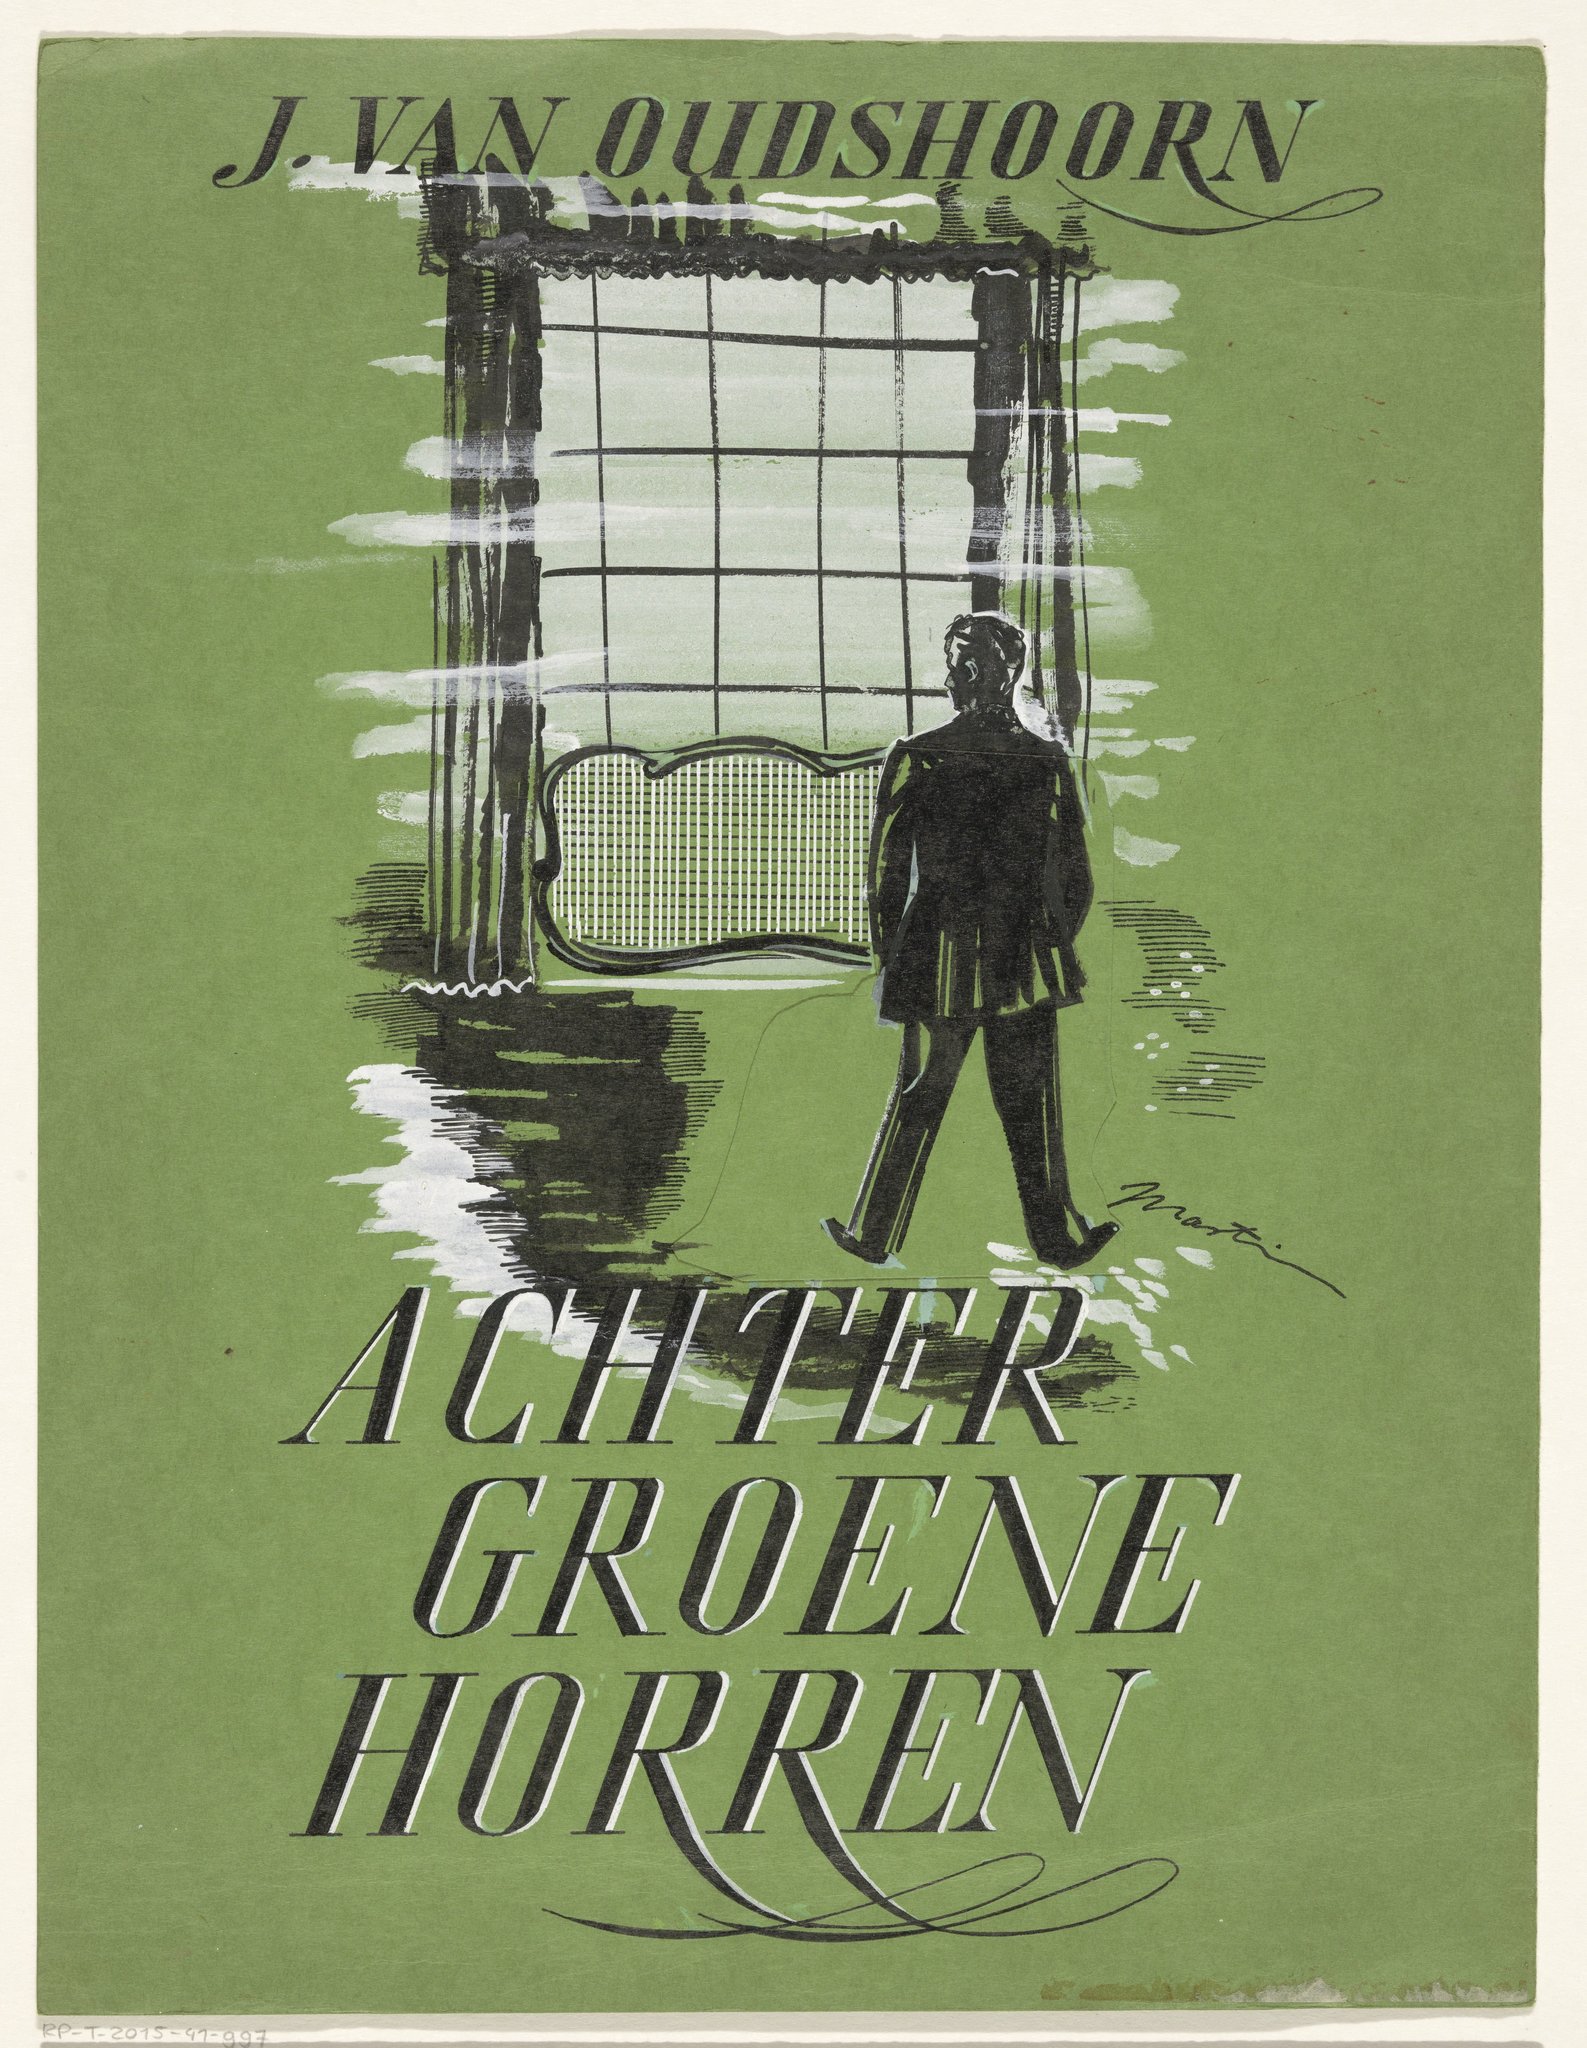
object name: study for binding design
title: Bandontwerp voor: J. van Oudshoorn, Achter groene horren, 1943-1945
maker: martin horwitz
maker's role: print maker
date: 1943-1945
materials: paint, ink, paper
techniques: brush, pen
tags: standing figure, window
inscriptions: signature: ‘Martin’, collector's mark: Lugt 2228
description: Een man staat wijdbeens voor een venster.